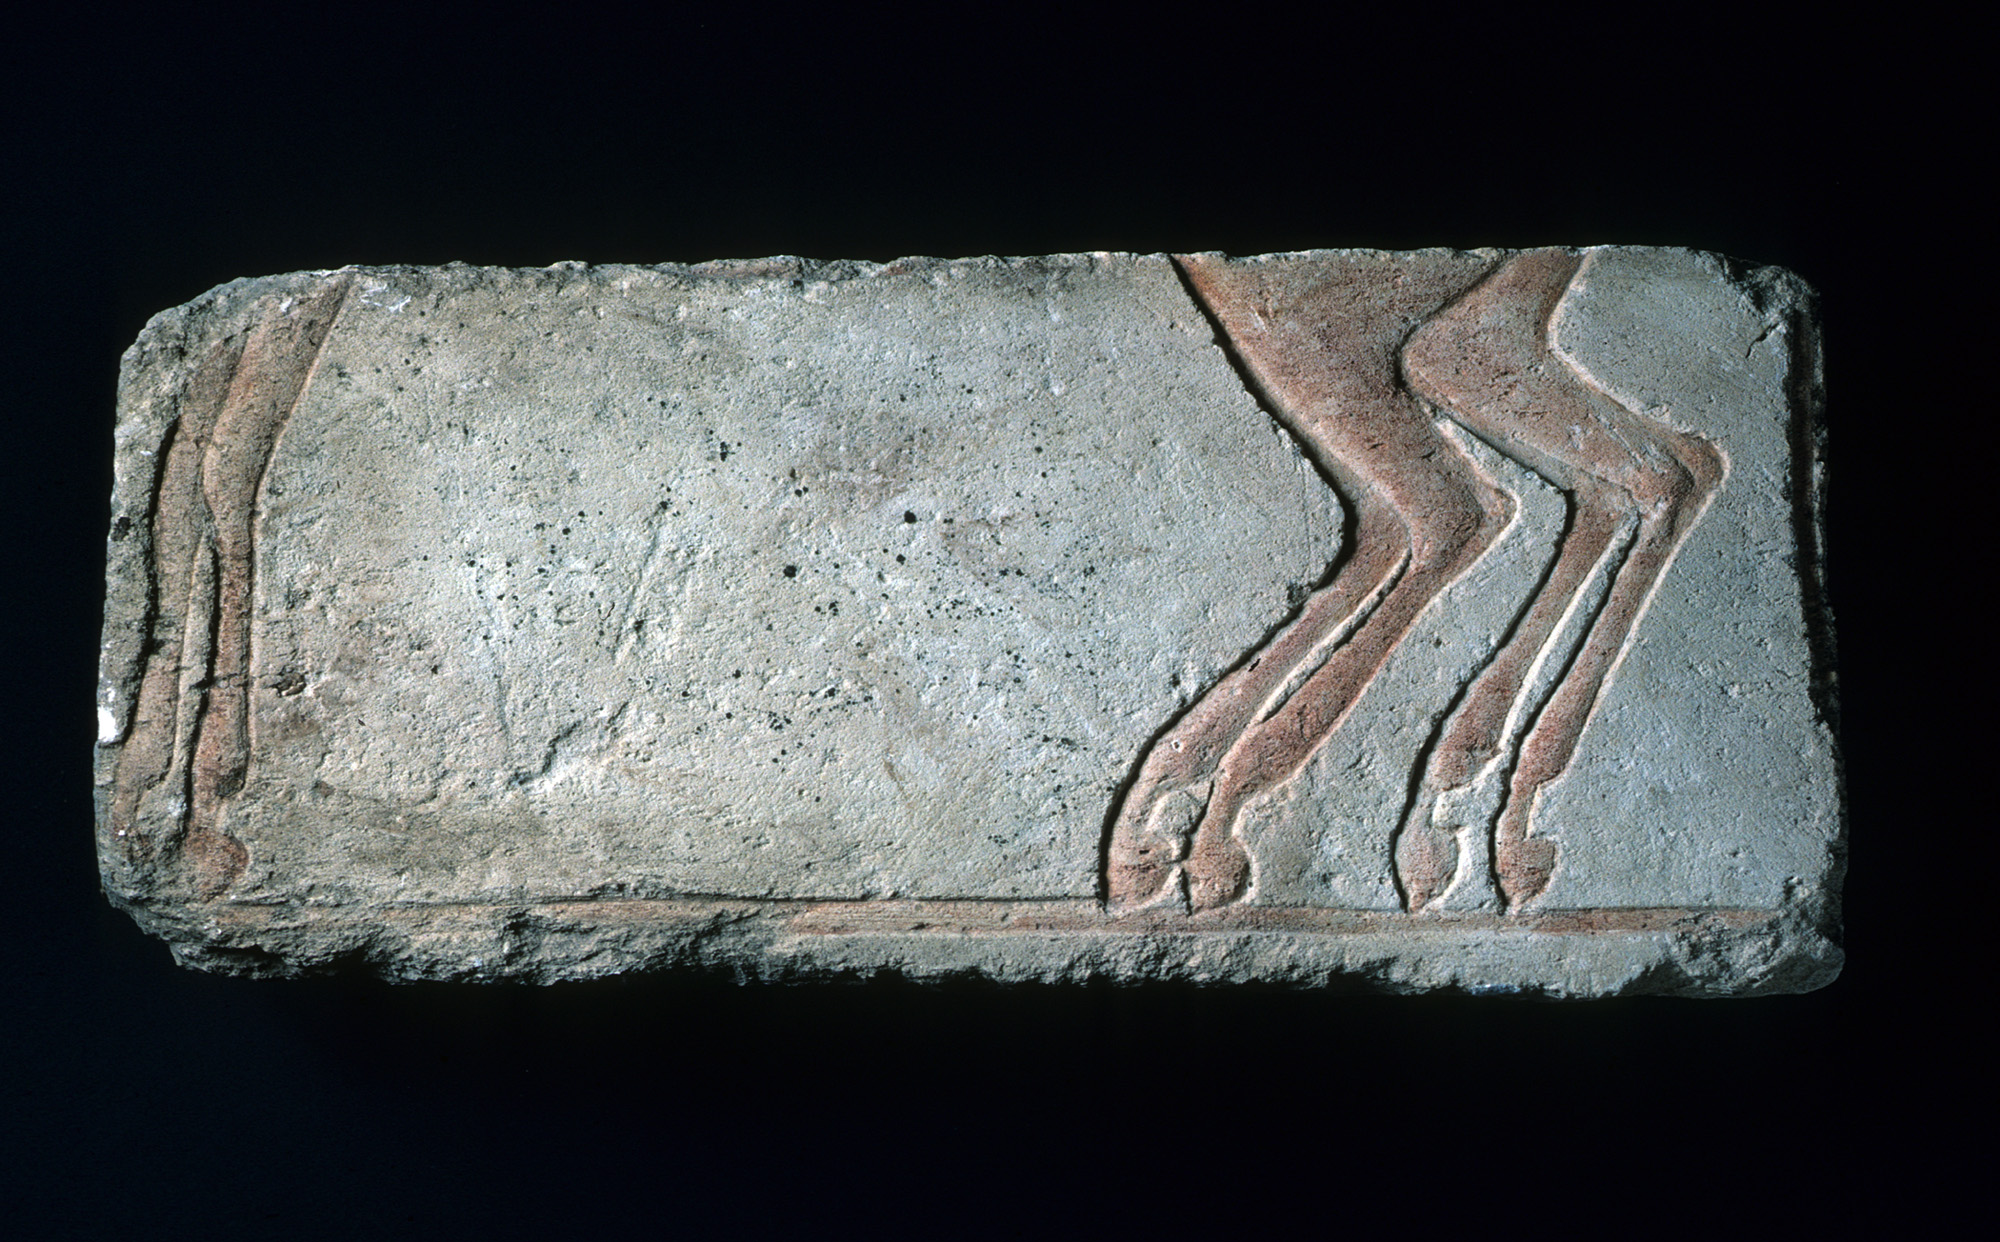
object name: talatat, horse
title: Relief horses' legs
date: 1353-1336 BCE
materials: limestone, paint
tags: horses